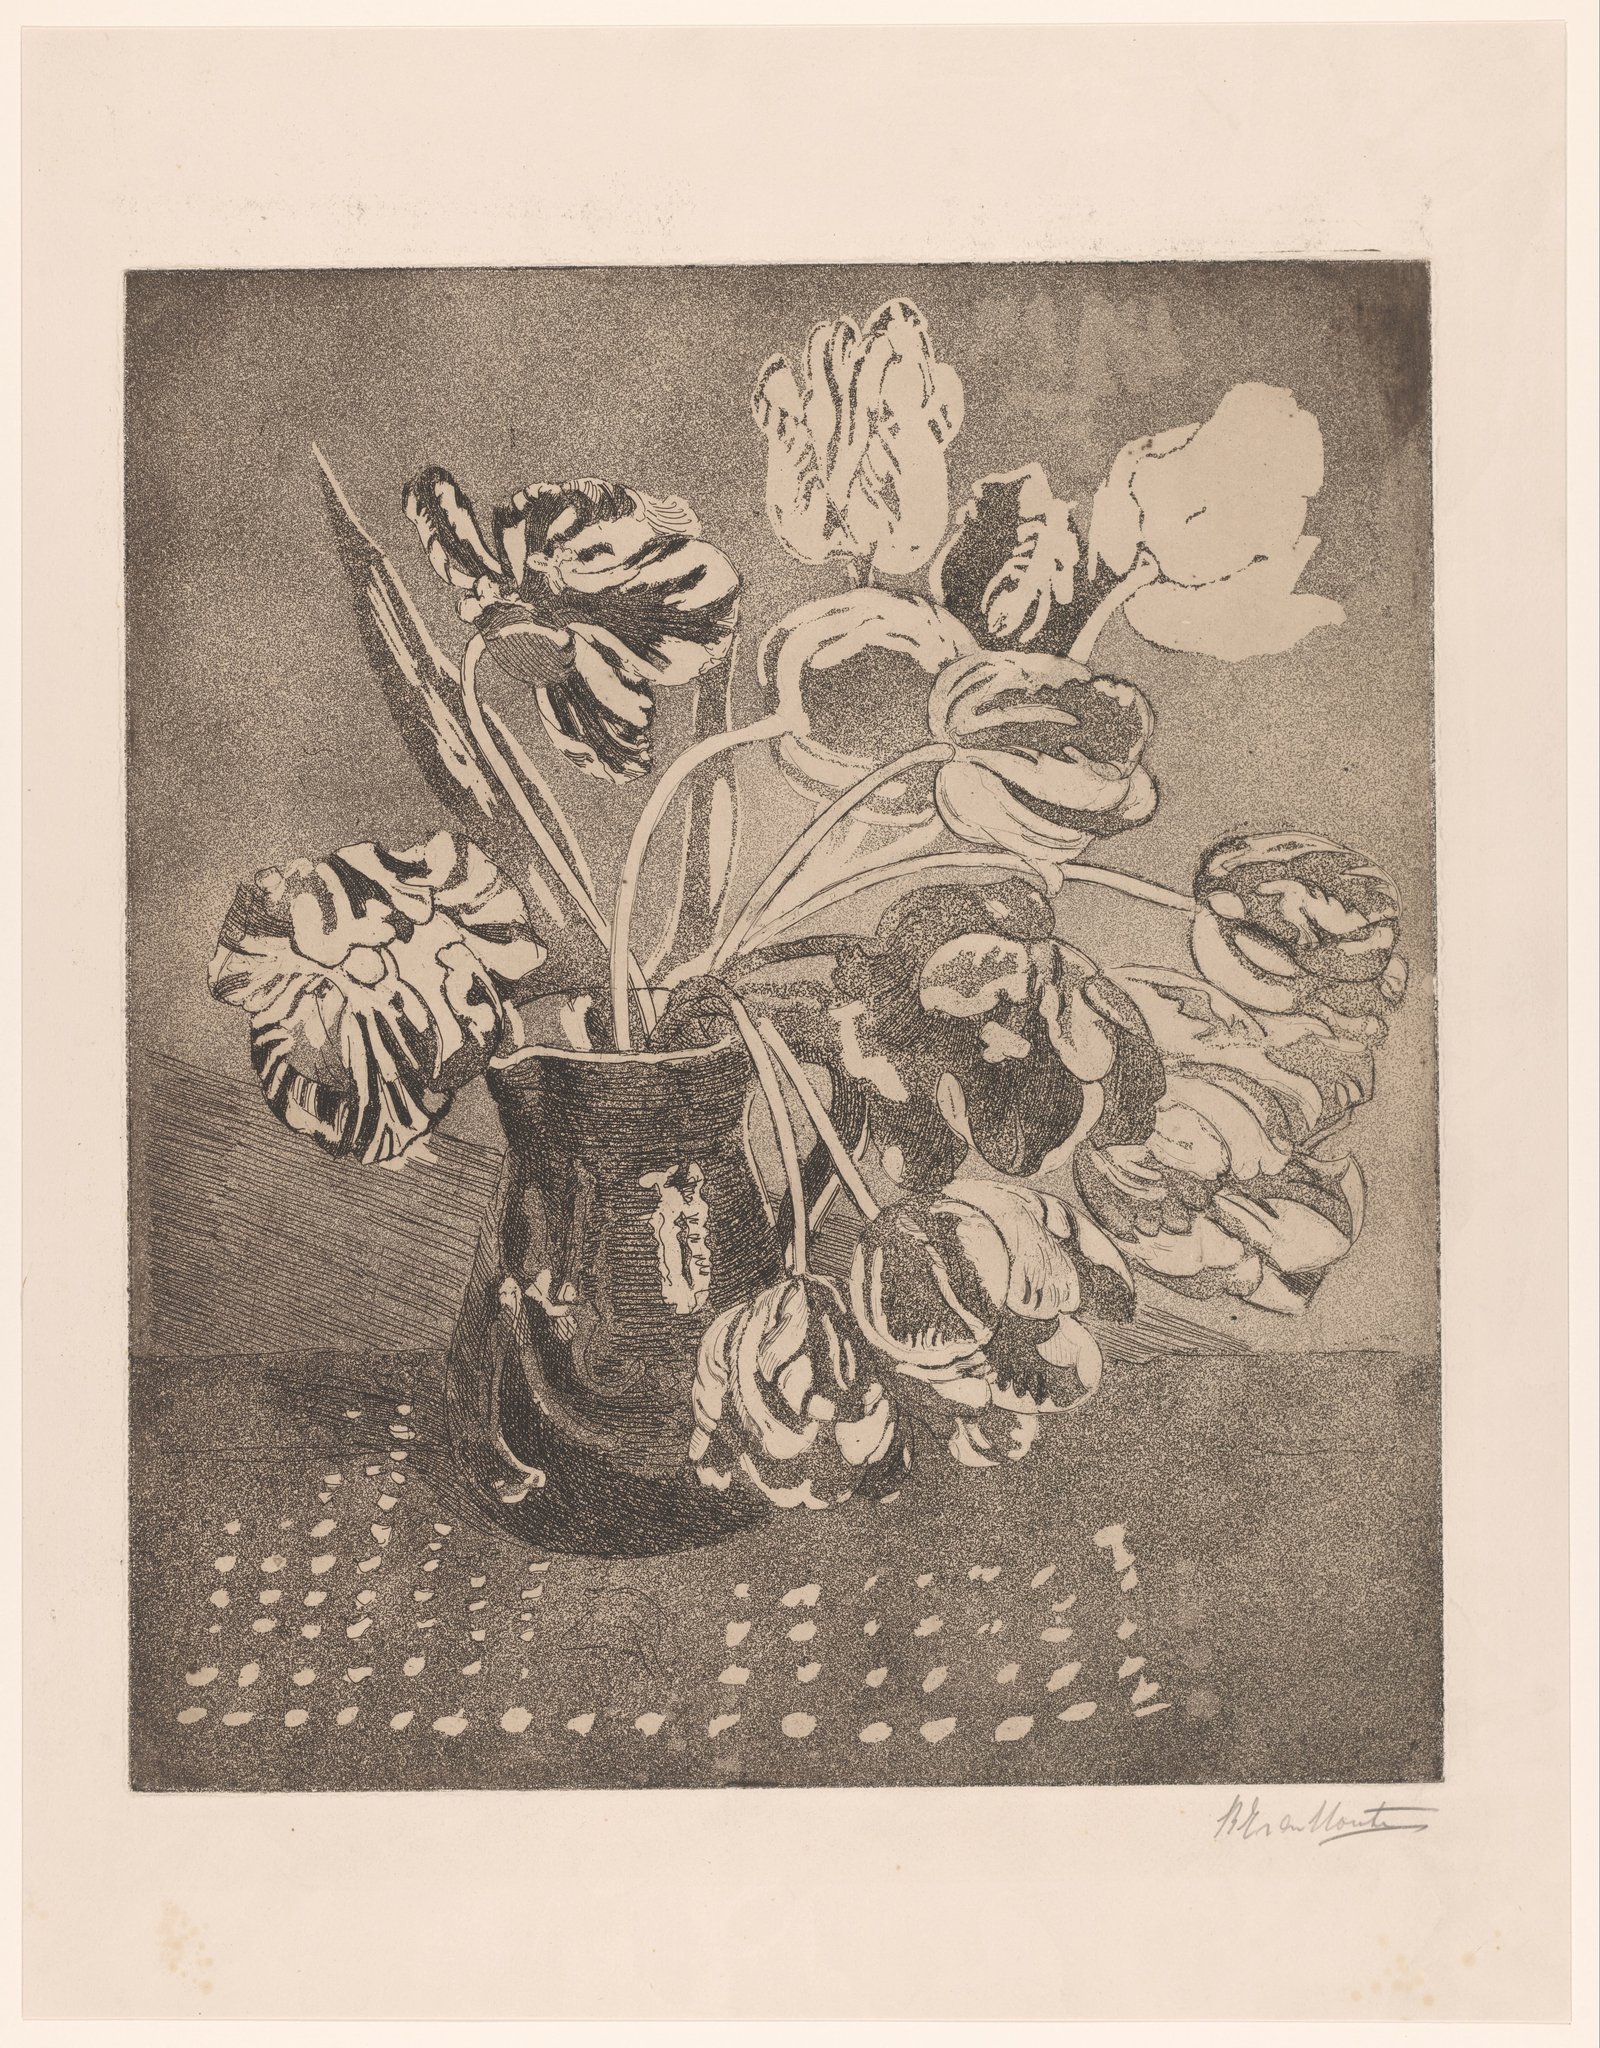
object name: print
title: Tulpen in een kan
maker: barbara elisabeth van houten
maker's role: draughtsman, print maker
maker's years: 1862-1950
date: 1872-1950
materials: paper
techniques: aquatint, etching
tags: flowers: tulip, flowers in a vase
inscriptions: collector's mark: Lugt 2228